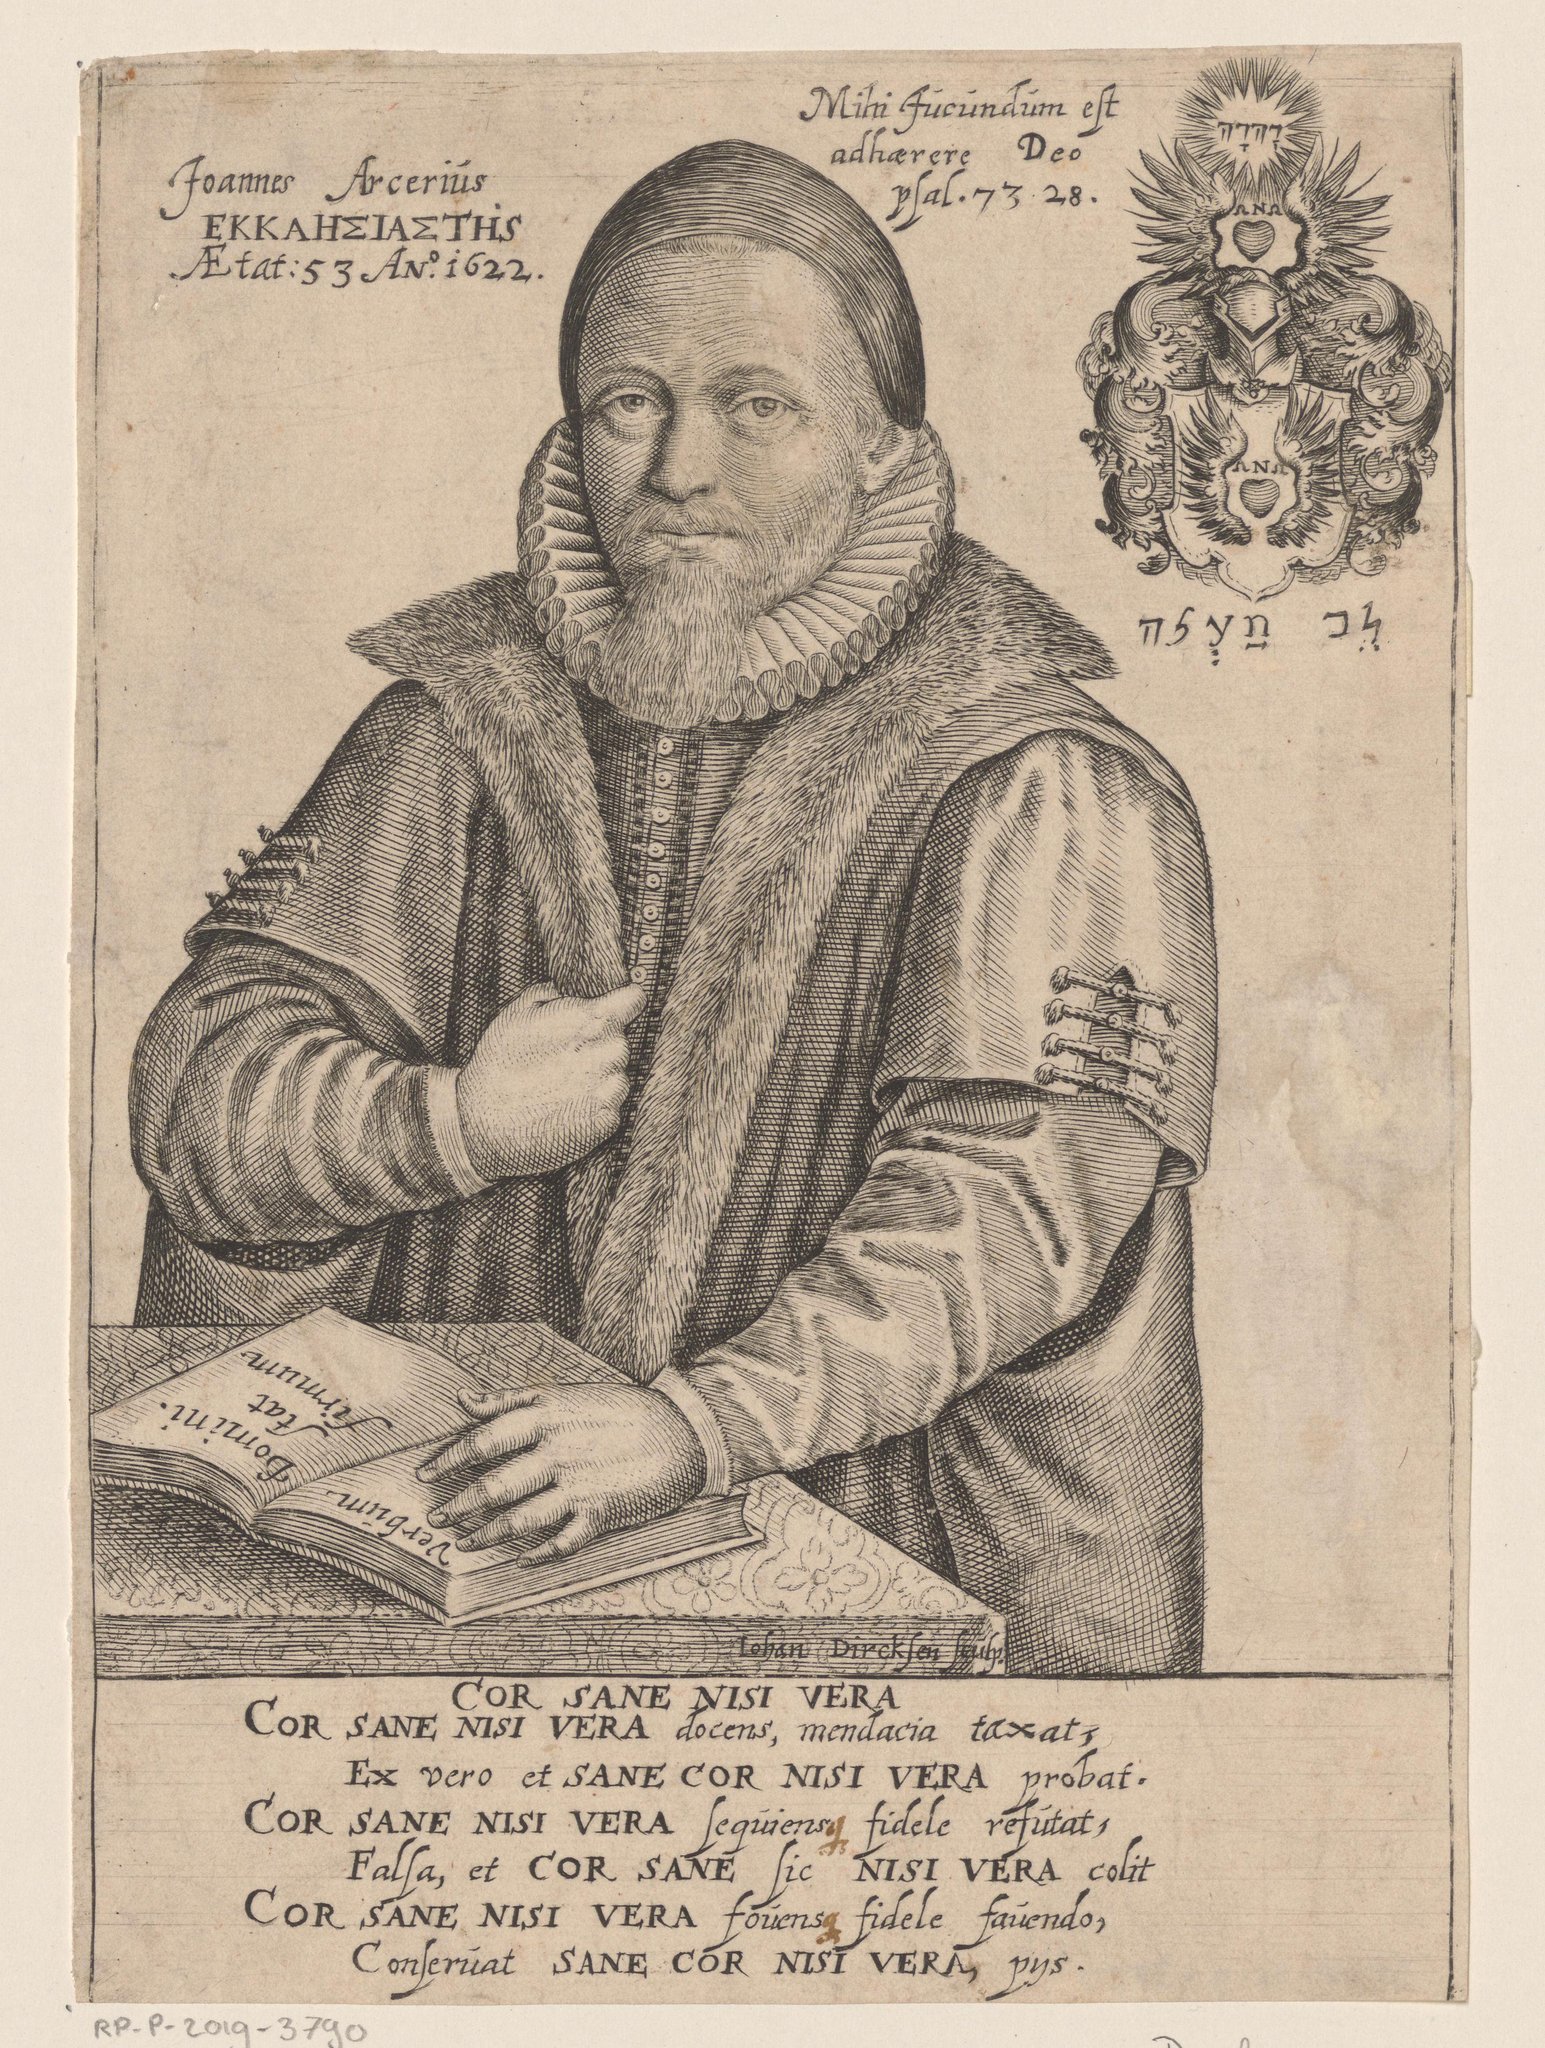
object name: print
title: Portret van Johannes Arcerius op 53-jarige leeftijd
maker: jan diricks van campen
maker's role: painter, print maker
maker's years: 1560-1622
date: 1622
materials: paper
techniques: engraving, etching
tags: theologian, historical persons, armorial bearing, heraldry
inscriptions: date